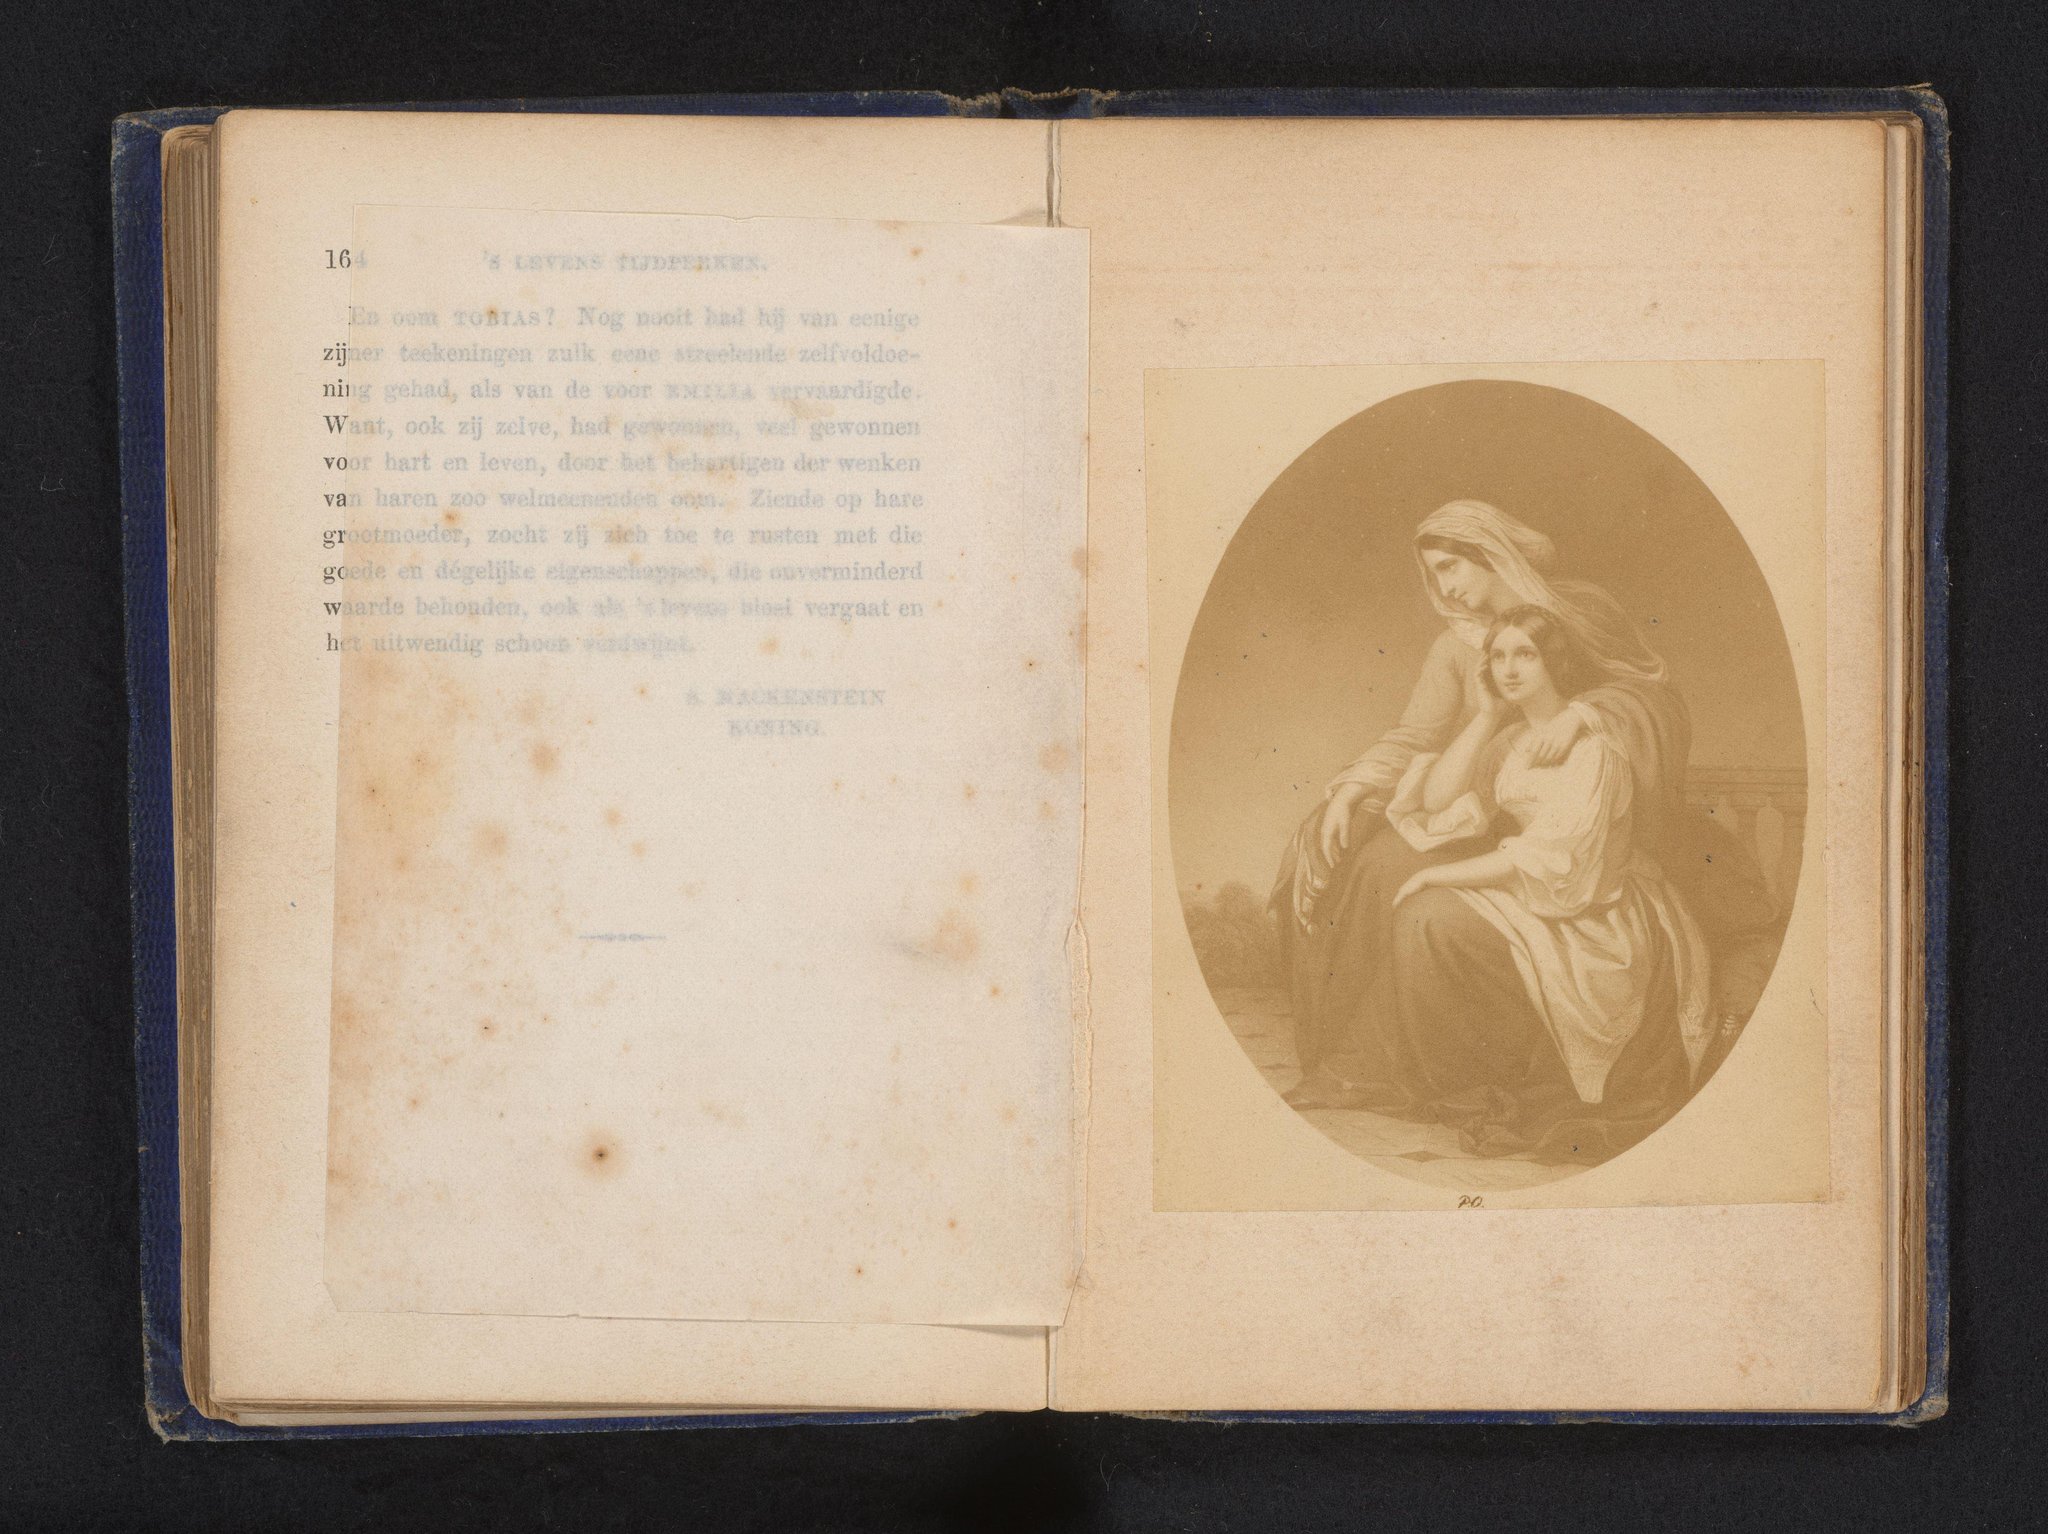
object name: photograph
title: Fotoreproductie van een schilderij van twee zittende vrouwen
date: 1855-1860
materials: paper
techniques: albumen print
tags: adult woman